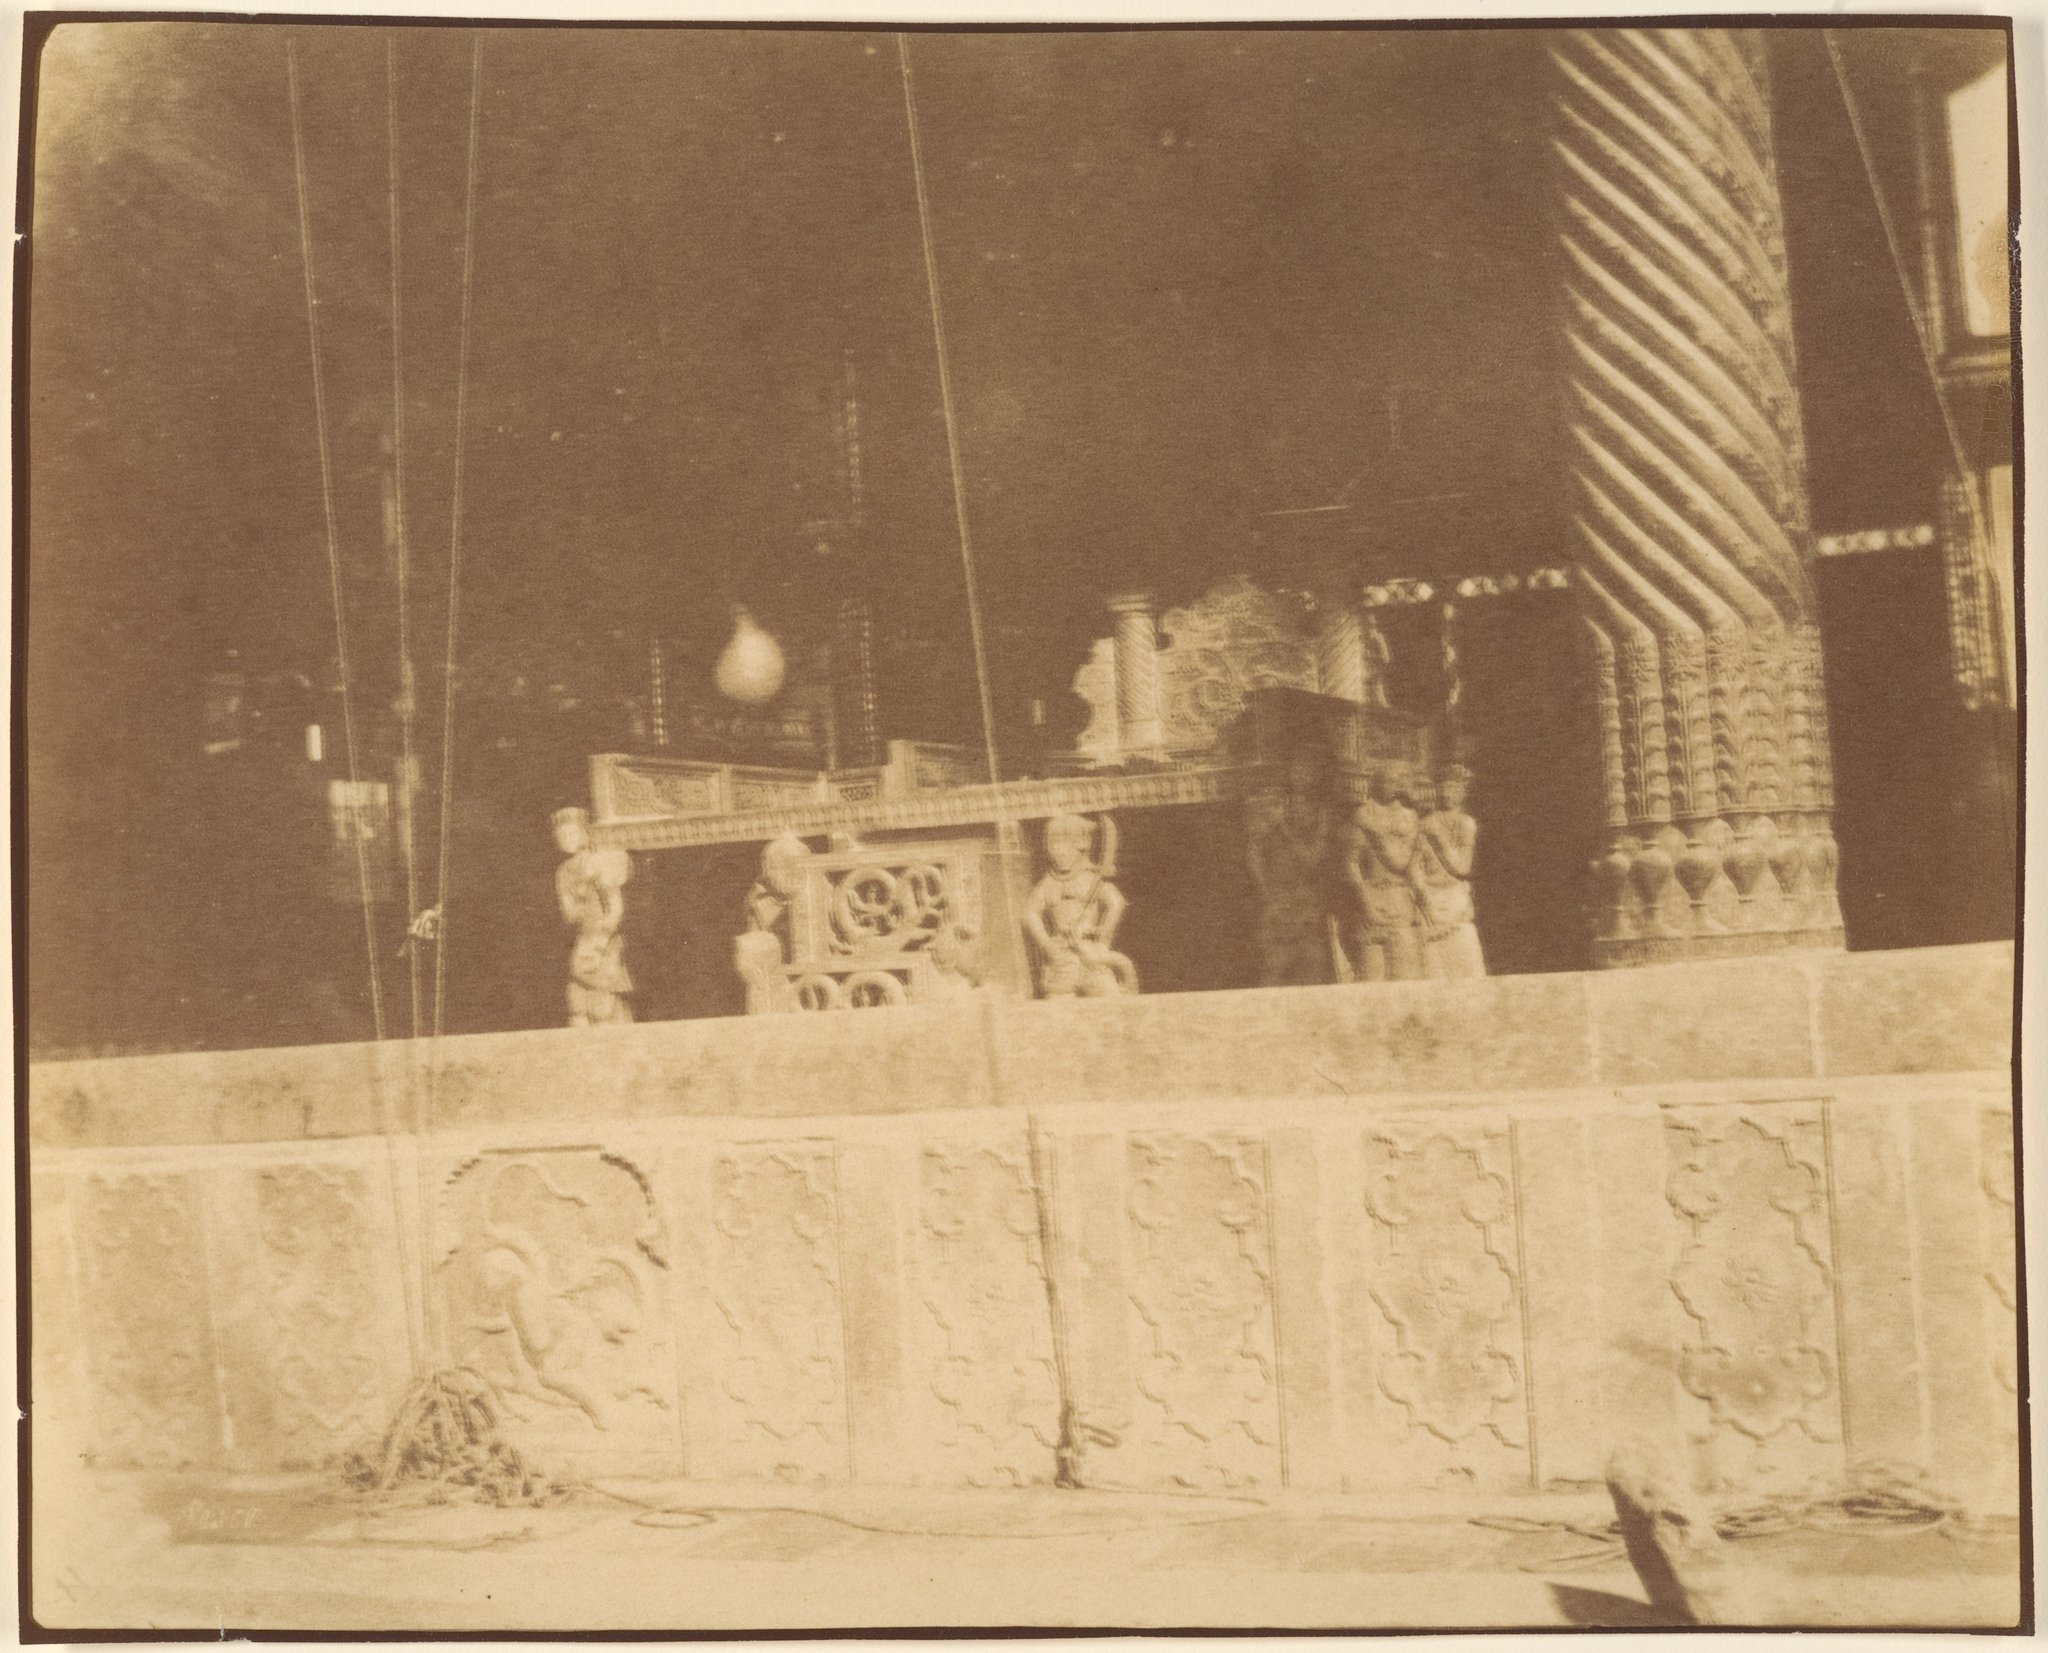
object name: photograph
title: [Golestan Palace, Teheran, Iran] (Takht-i Marmor)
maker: luigi pesce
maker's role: artist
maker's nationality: italian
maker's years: 1818-1891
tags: architecture,columns